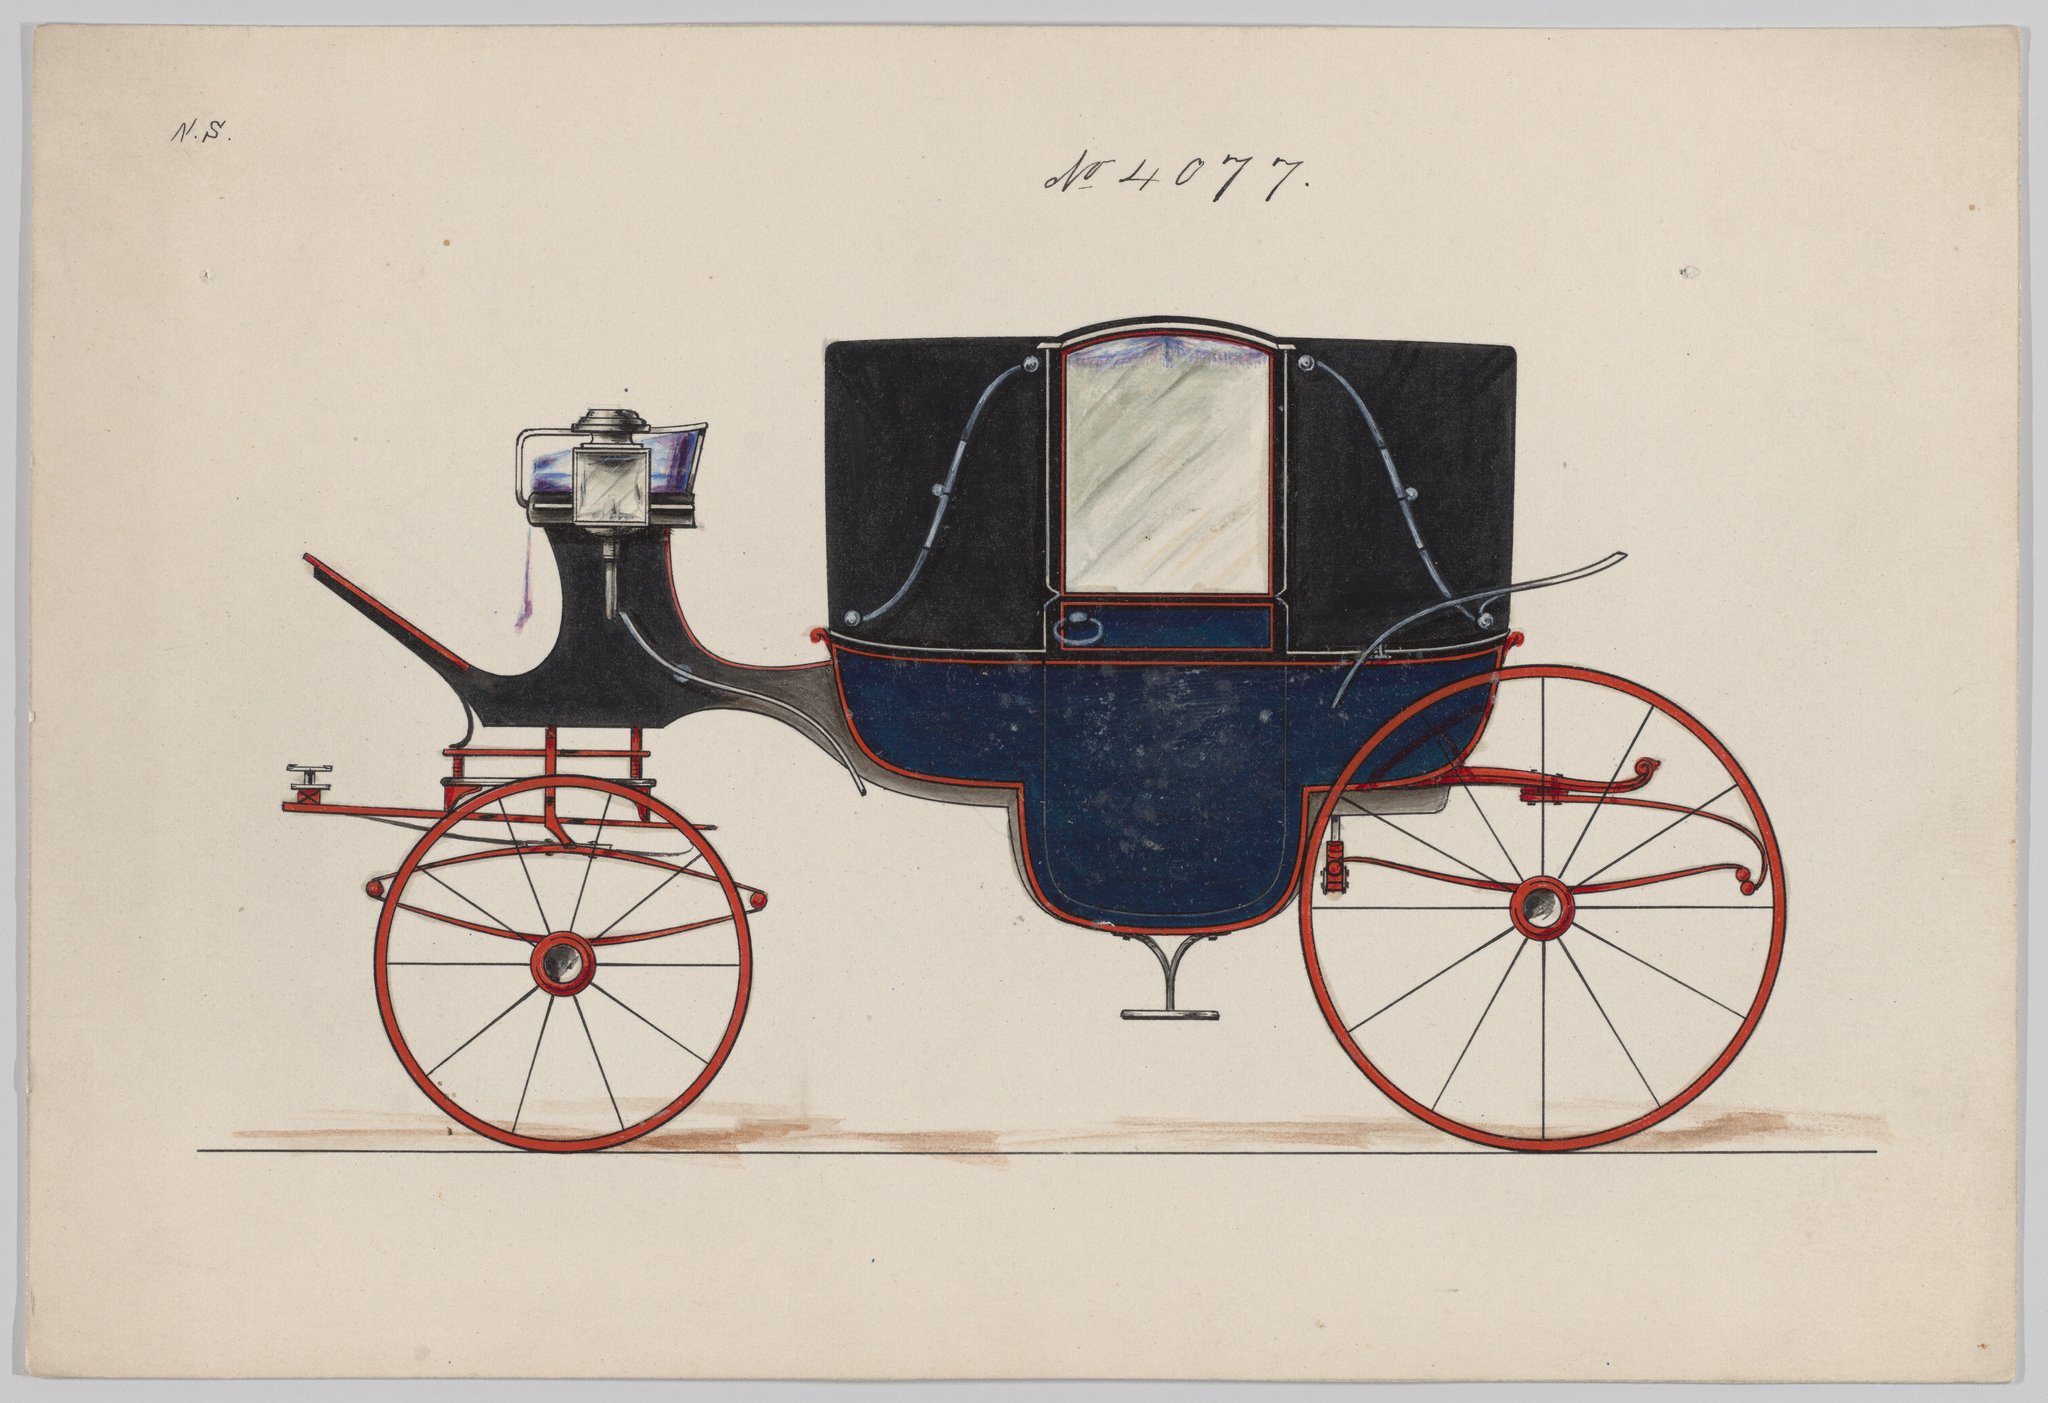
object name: drawing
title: Design for Landau, No. 4077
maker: brewster & co.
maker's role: manufacturer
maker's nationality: american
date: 1890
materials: gouache, gum arabic, ink, watercolor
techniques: pen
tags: carriages